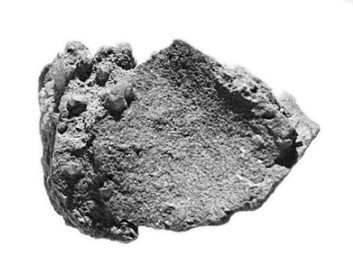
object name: sealing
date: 1981-1640 BCE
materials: mud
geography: egypt